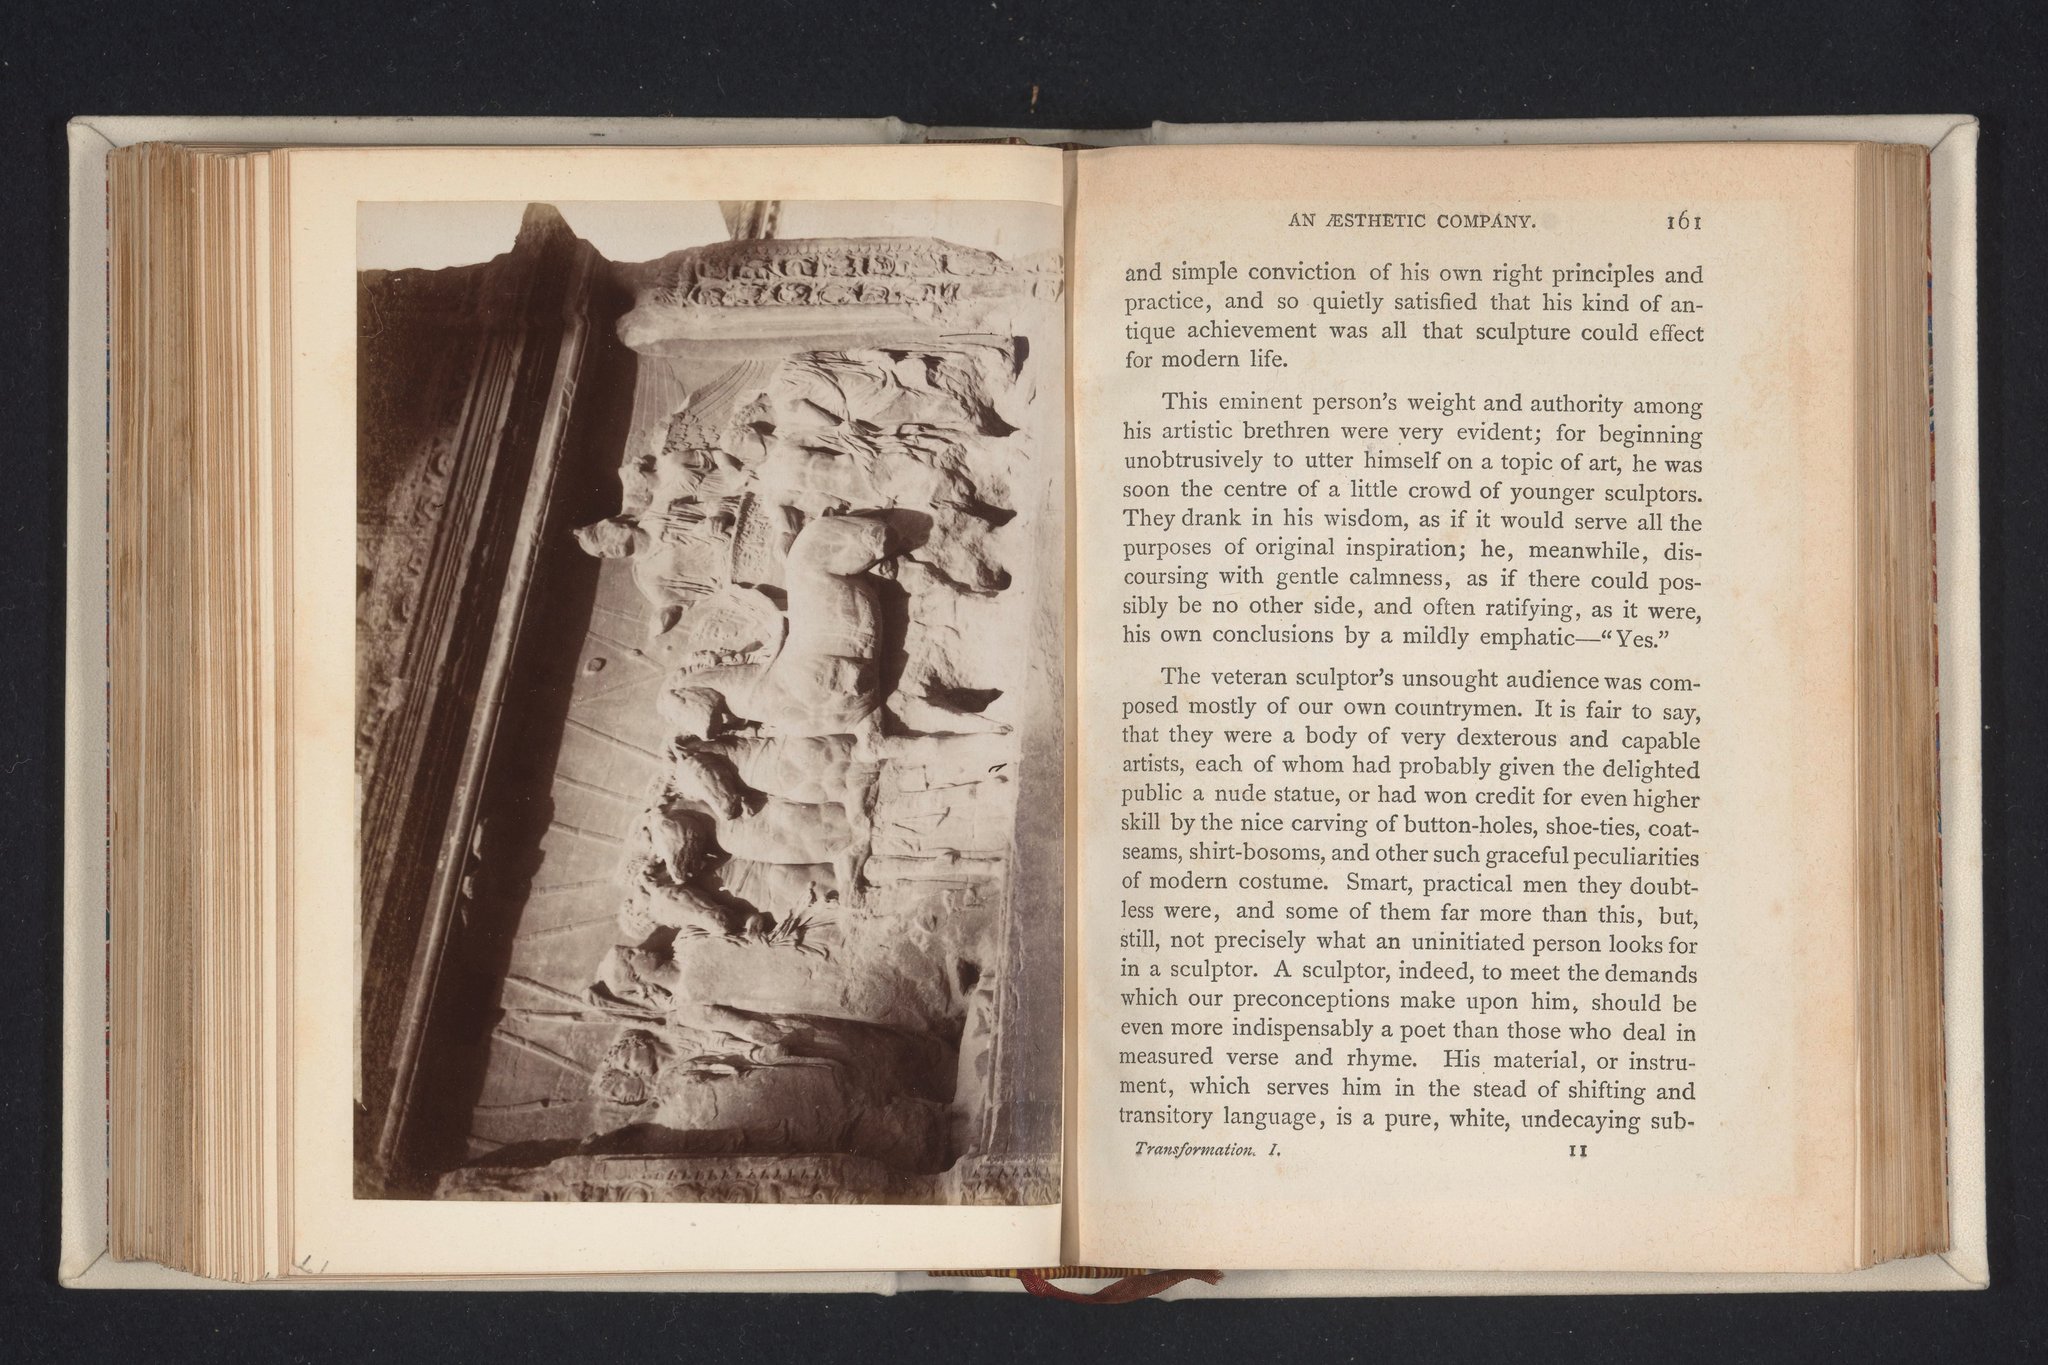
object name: photograph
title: Wandreliëf met een triomfwagen en paarden, vermoedelijk in Rome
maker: Anonymous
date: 1850-1860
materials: photographic support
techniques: albumen print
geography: rome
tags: ancient forms of military vehicles: chariot, battle wagon, etc., decorating 'en relief', appliquéing